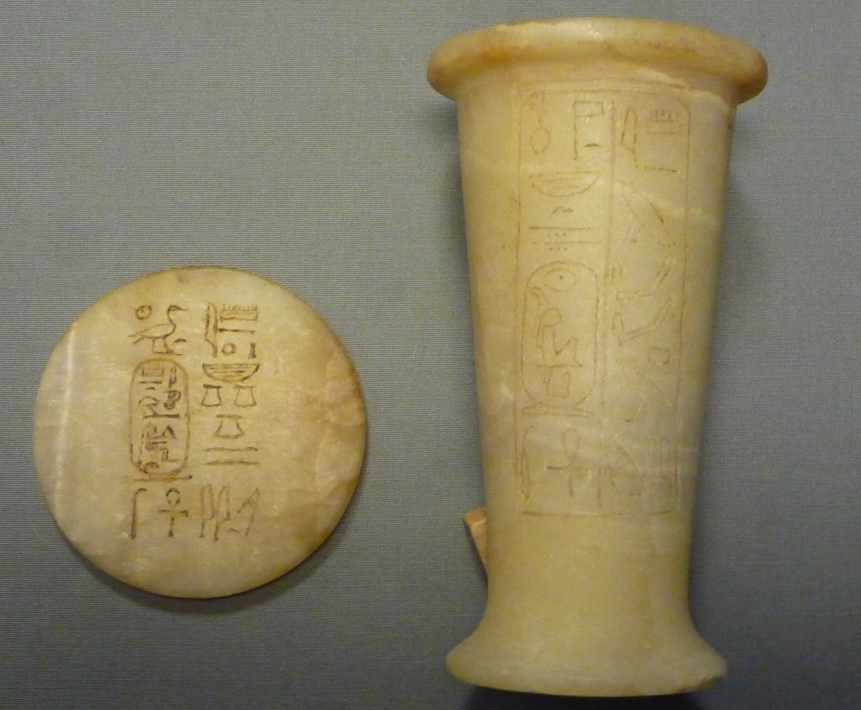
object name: ointment jar, foundation deposit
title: Ointment Jar from a Foundation Deposit of Hatshepsut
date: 1479-1458 BCE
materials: paint, stone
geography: egypt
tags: hieroglyphs